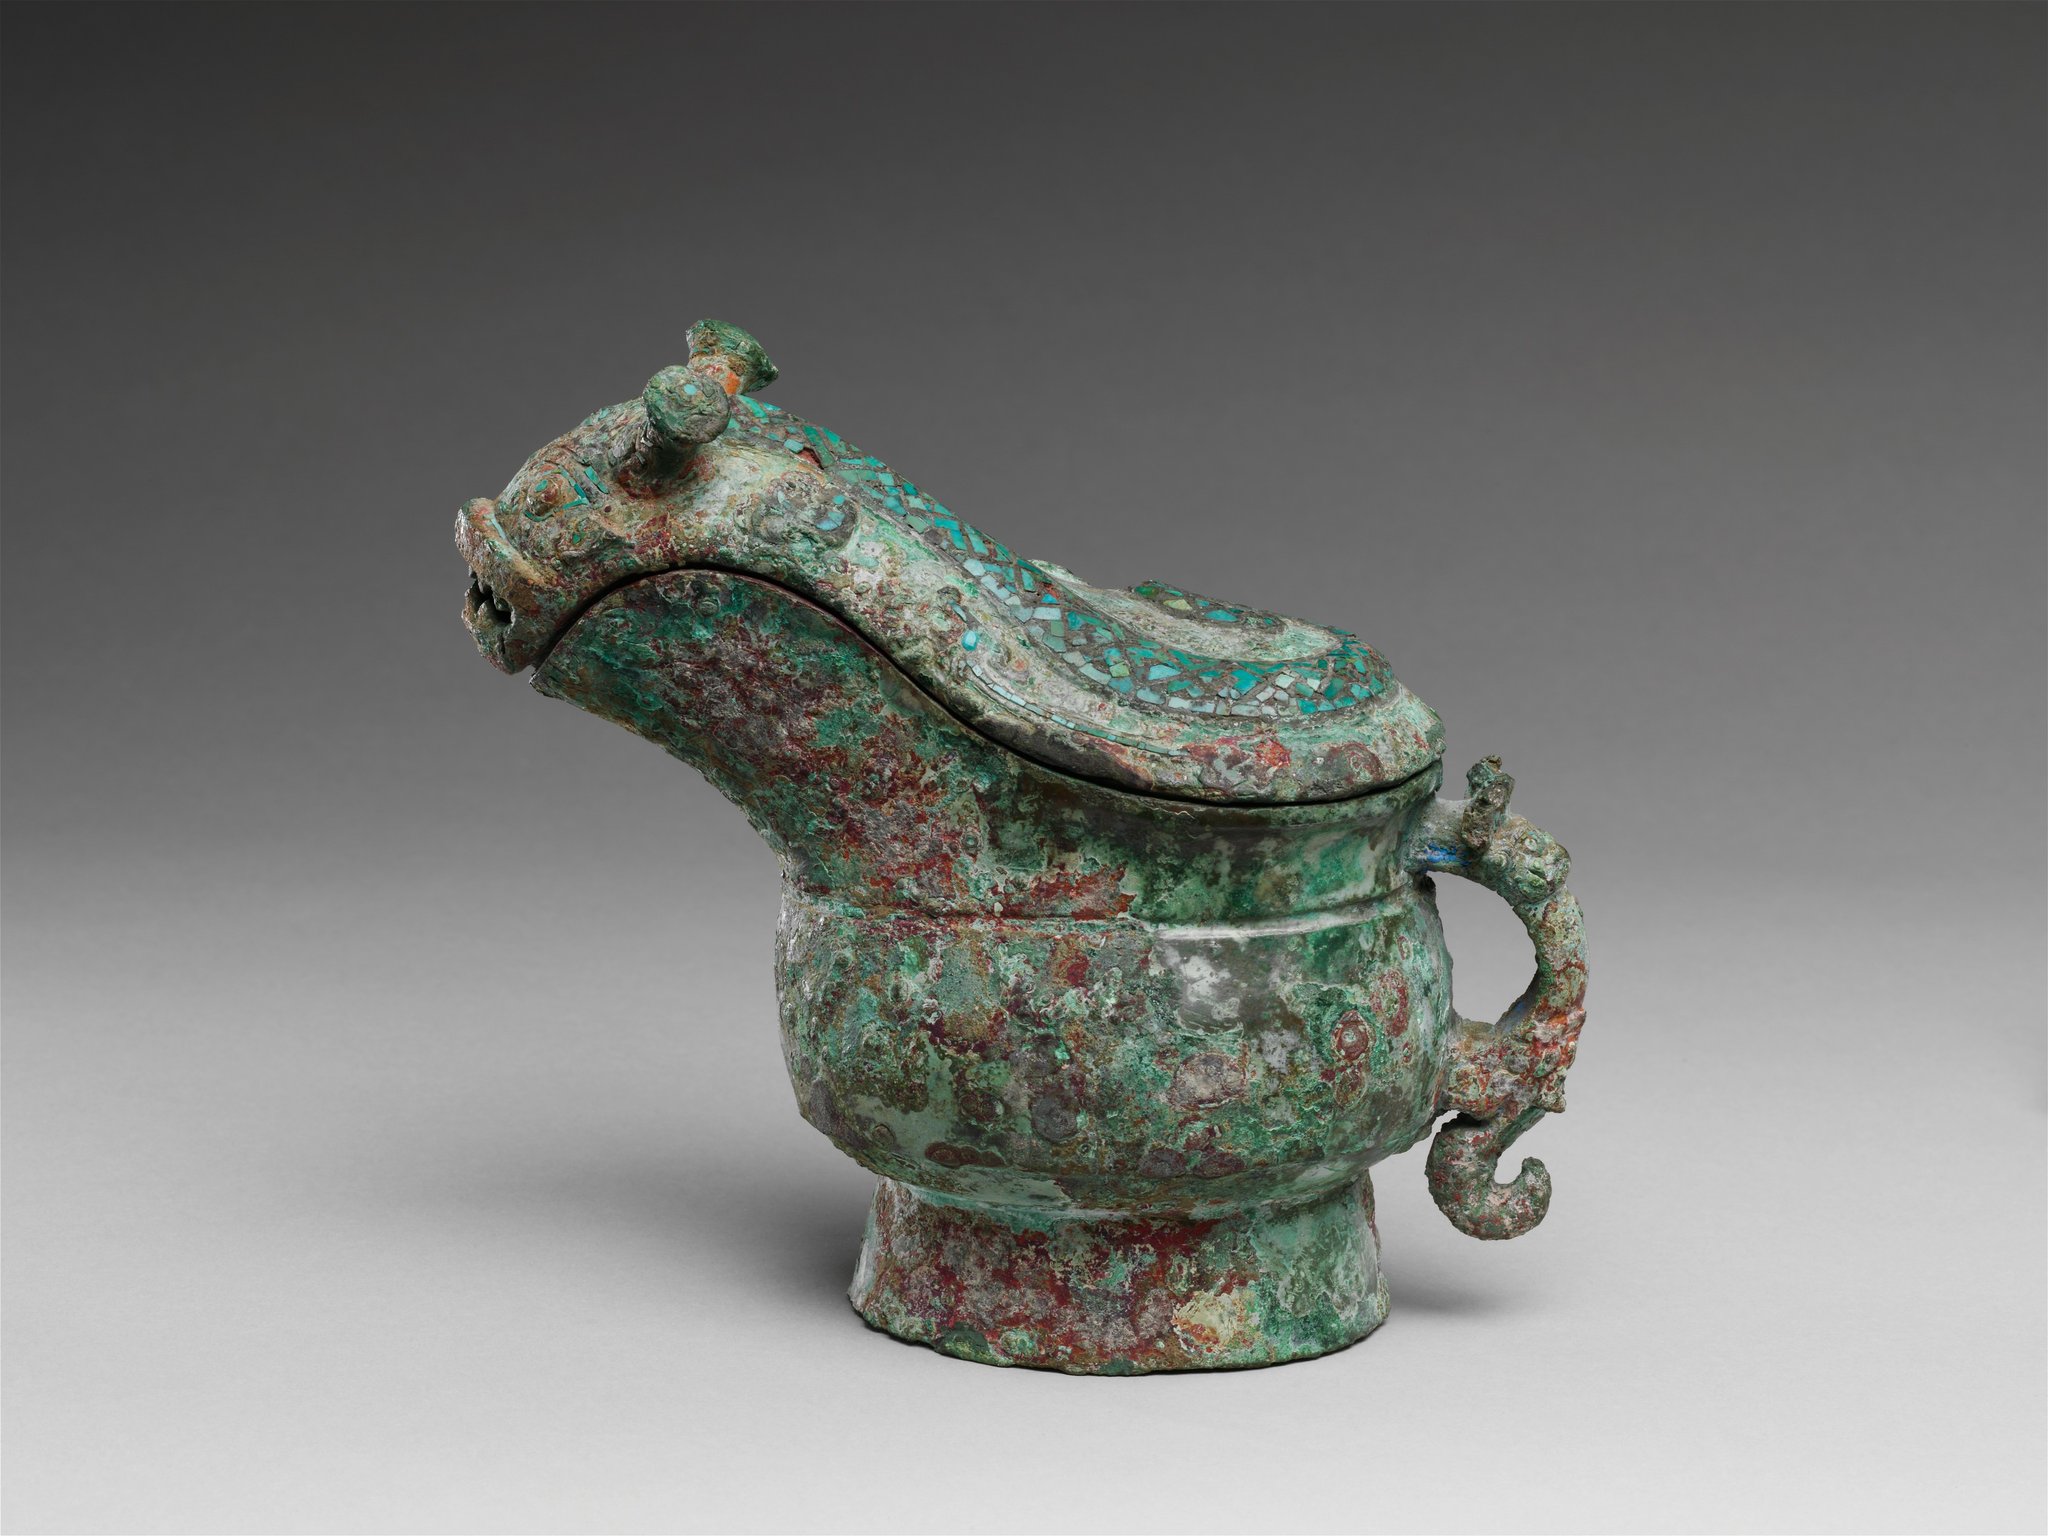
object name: wine vessel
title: Wine pouring vessel (Gong)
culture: chinese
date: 1200-1101 BCE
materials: bronze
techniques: inlay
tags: animals